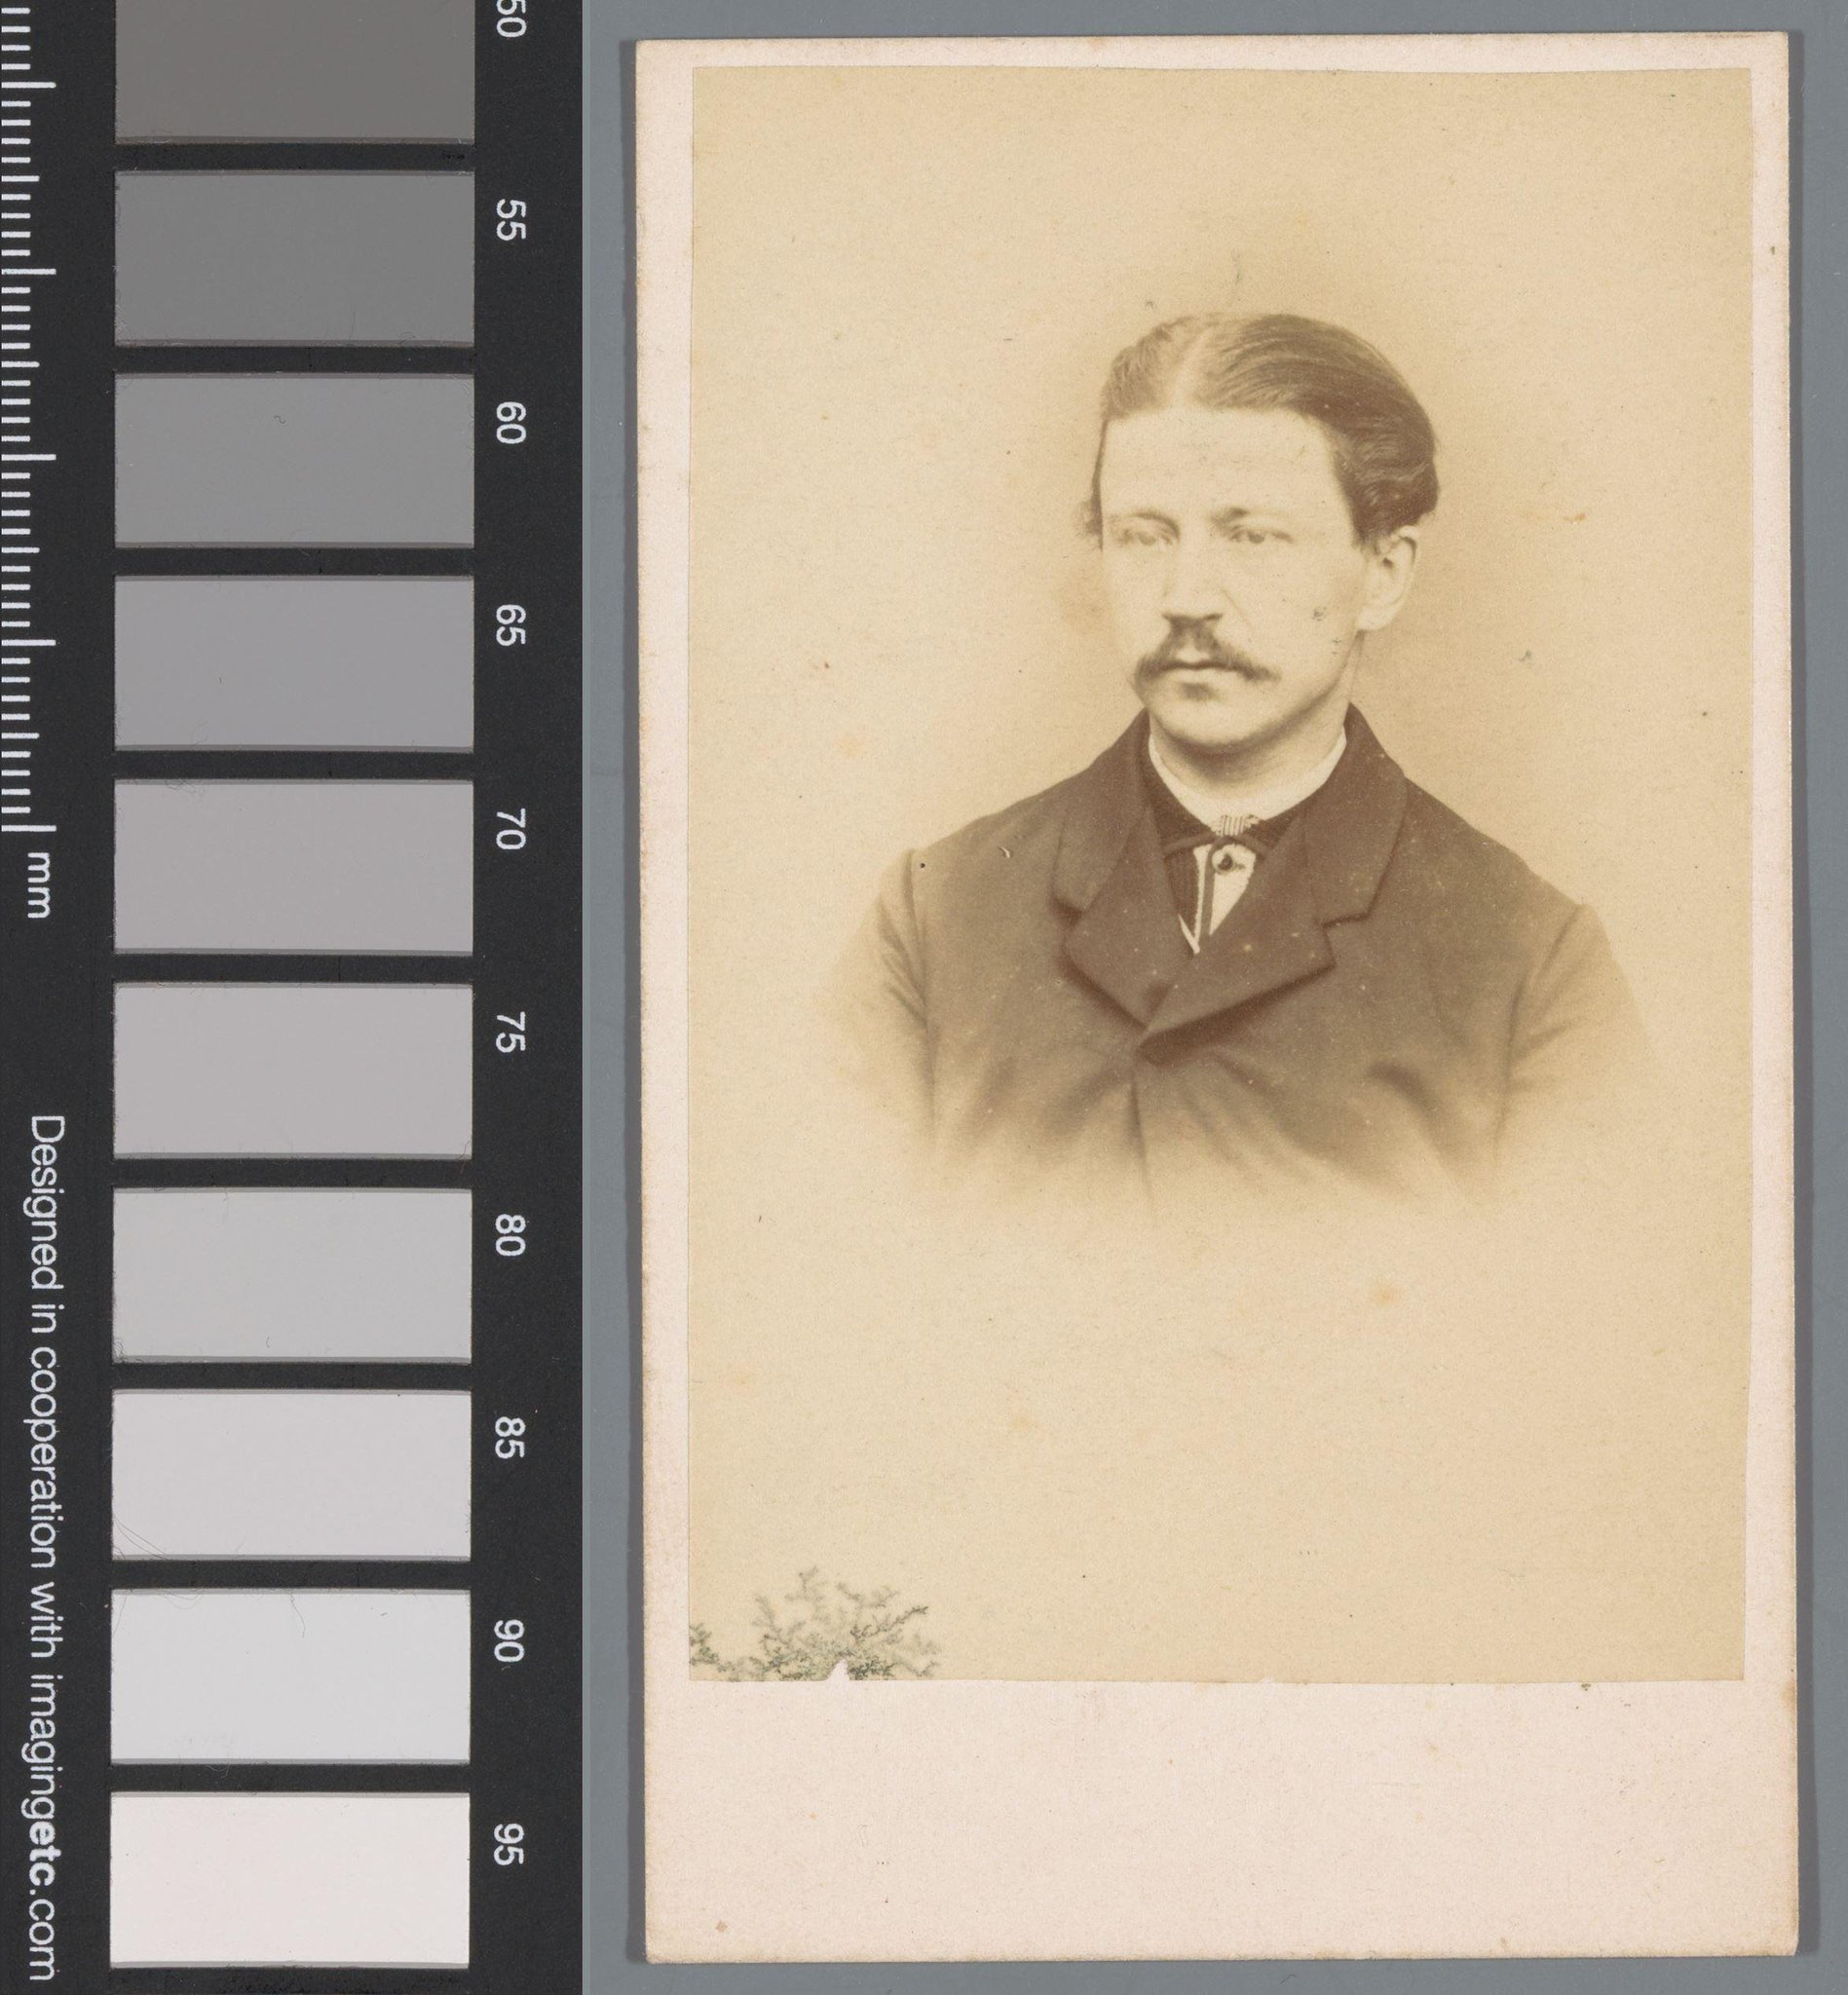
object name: photograph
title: Portret van een onbekende man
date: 1875-1882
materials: cardboard, paper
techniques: albumen print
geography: antwerp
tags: adult man, anonymous historical person portrayed, antwerp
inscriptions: inscription: ‘J. van Crewel/ Photographe/ Atelier dans le jardin/ Rue du Chaperon No6/ Anvers’